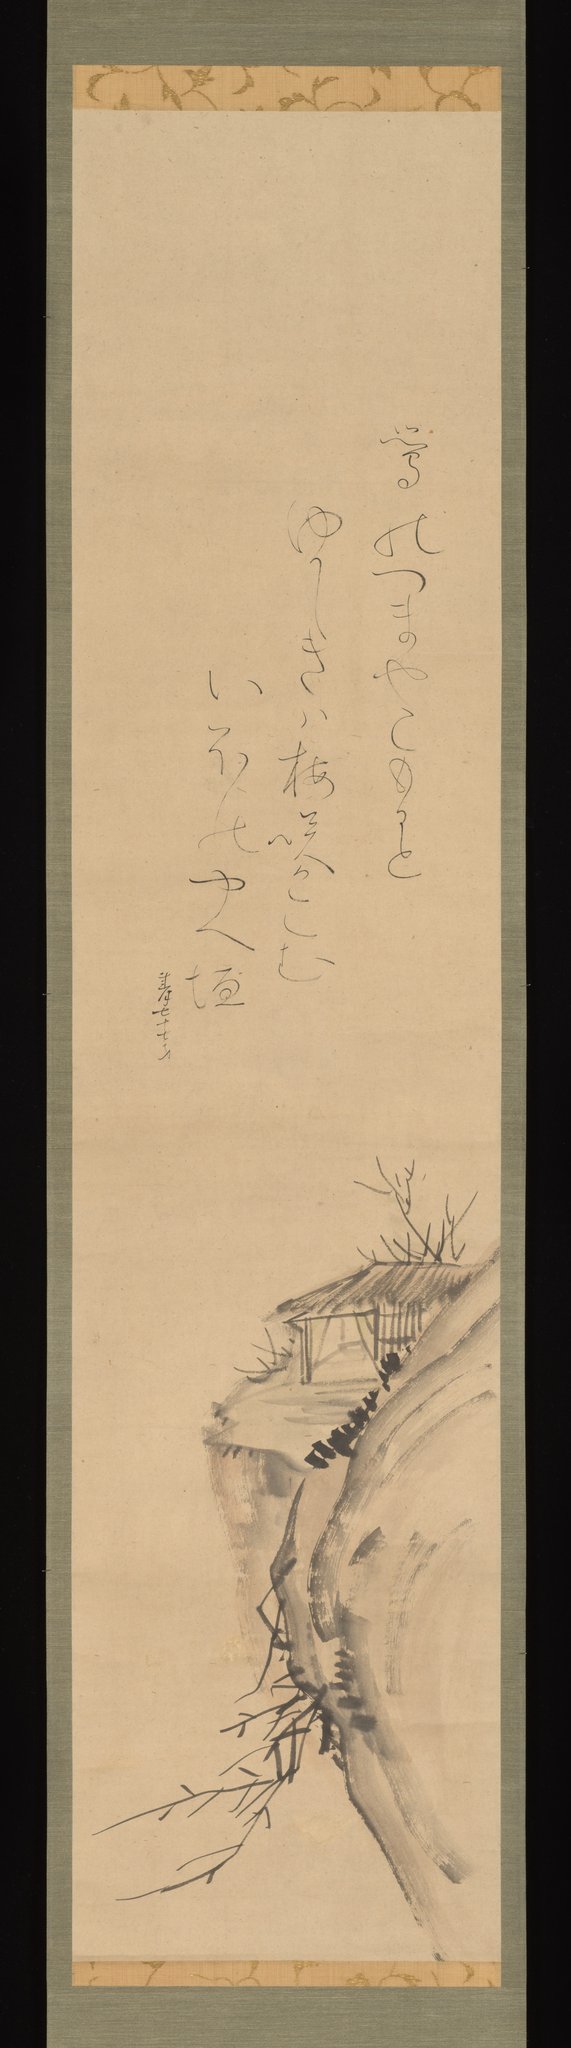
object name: hanging scroll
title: Poem-painting “When the nightingale returns...”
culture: japanese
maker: ōtagaki rengetsu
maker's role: artist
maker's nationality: japanese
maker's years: 1791-1875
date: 1867-1900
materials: ink, paper